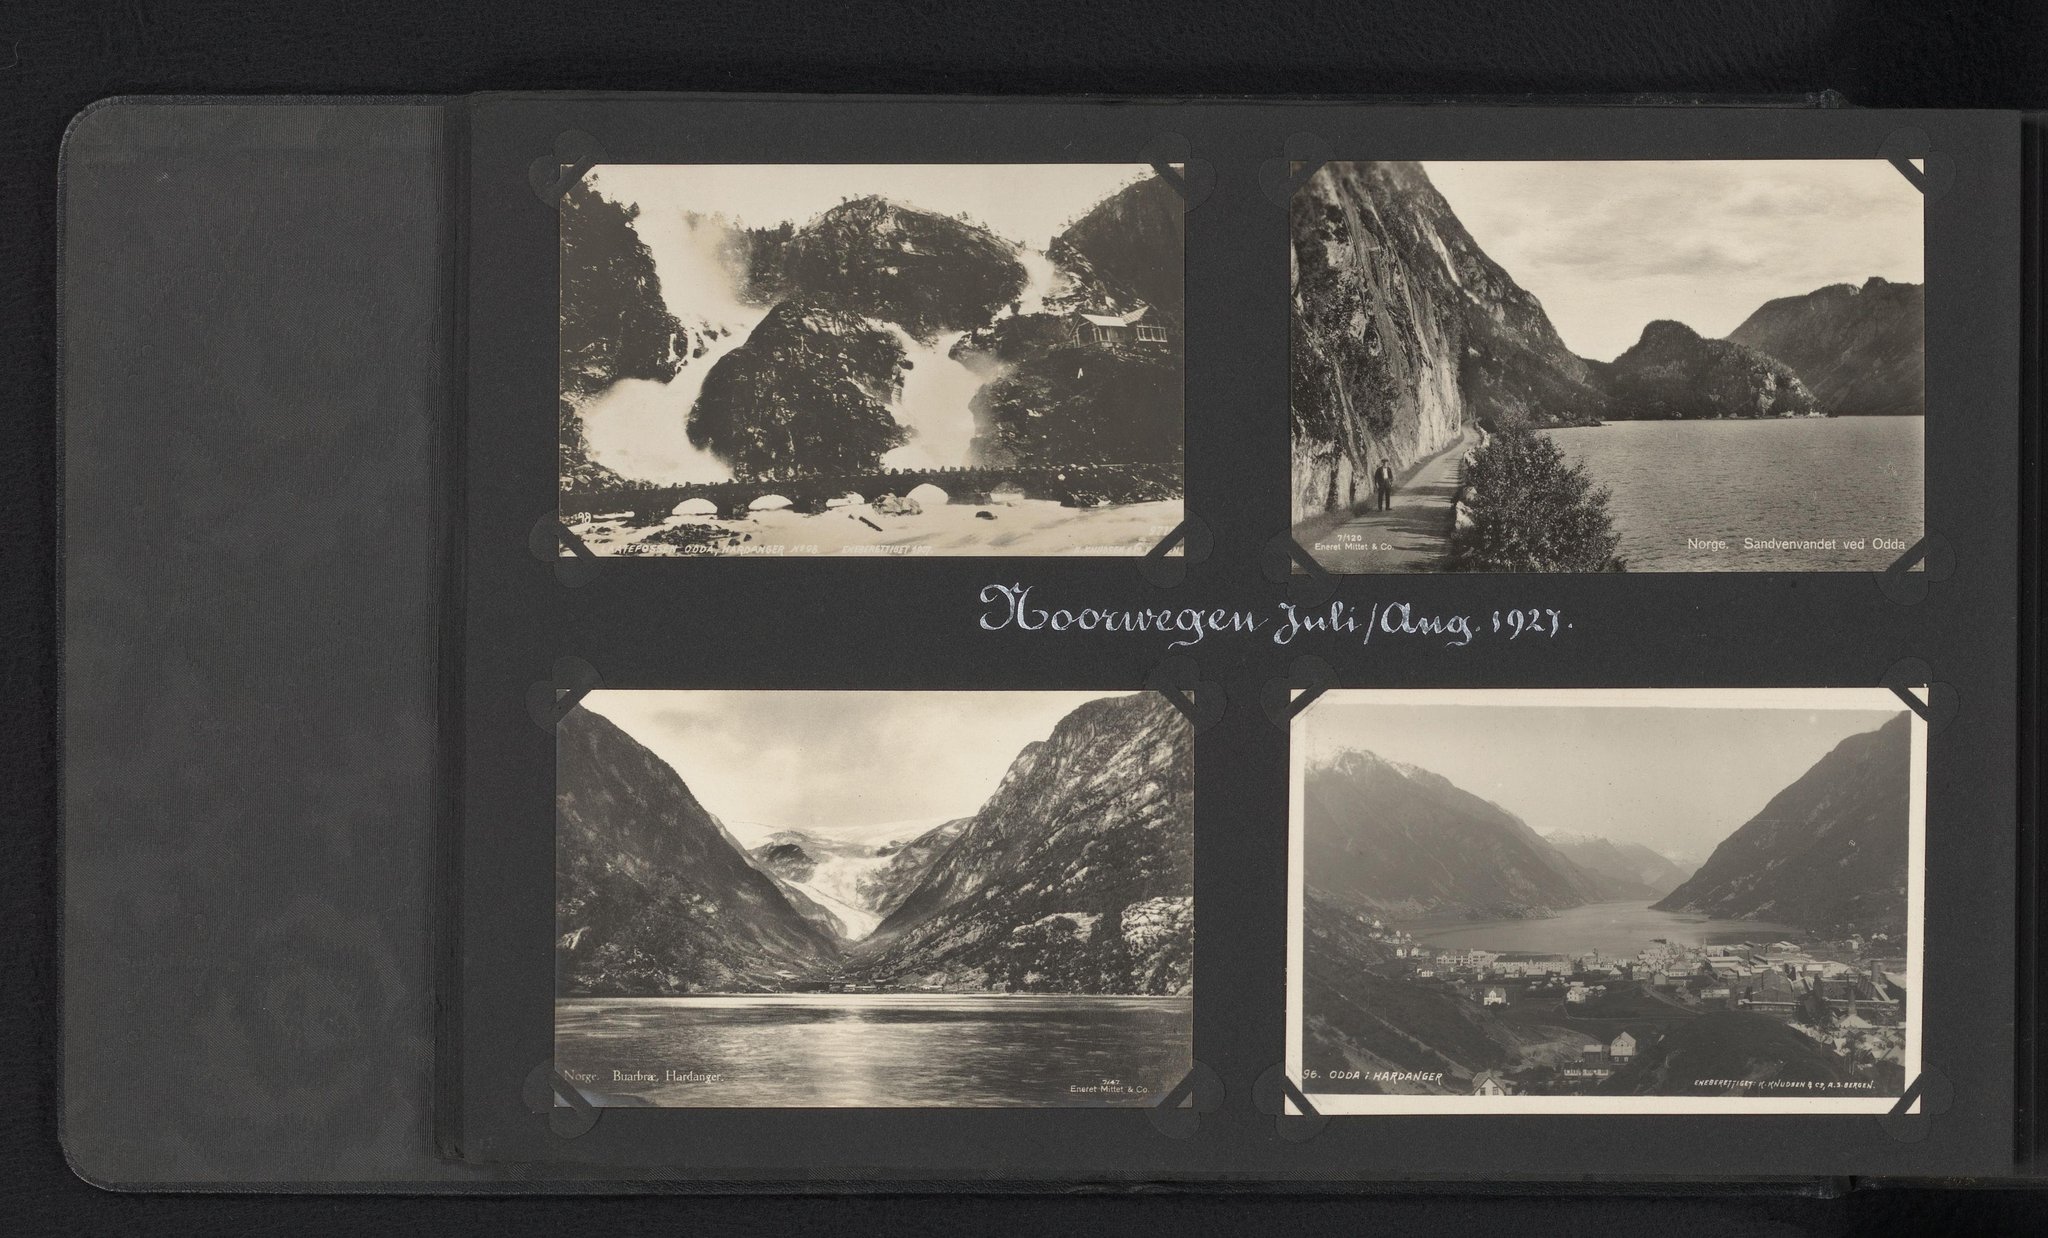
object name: ansichtkaart, prentbriefkaart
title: Vier fotografische prentbriefkaarten van landschappen in Noorwegen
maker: knud knudsen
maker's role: fotograaf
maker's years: 1832-1915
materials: paper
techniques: gelatin silver print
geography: norway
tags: fjord, sea loch, mountains, norway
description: Deze foto's maken deel uit van een album.